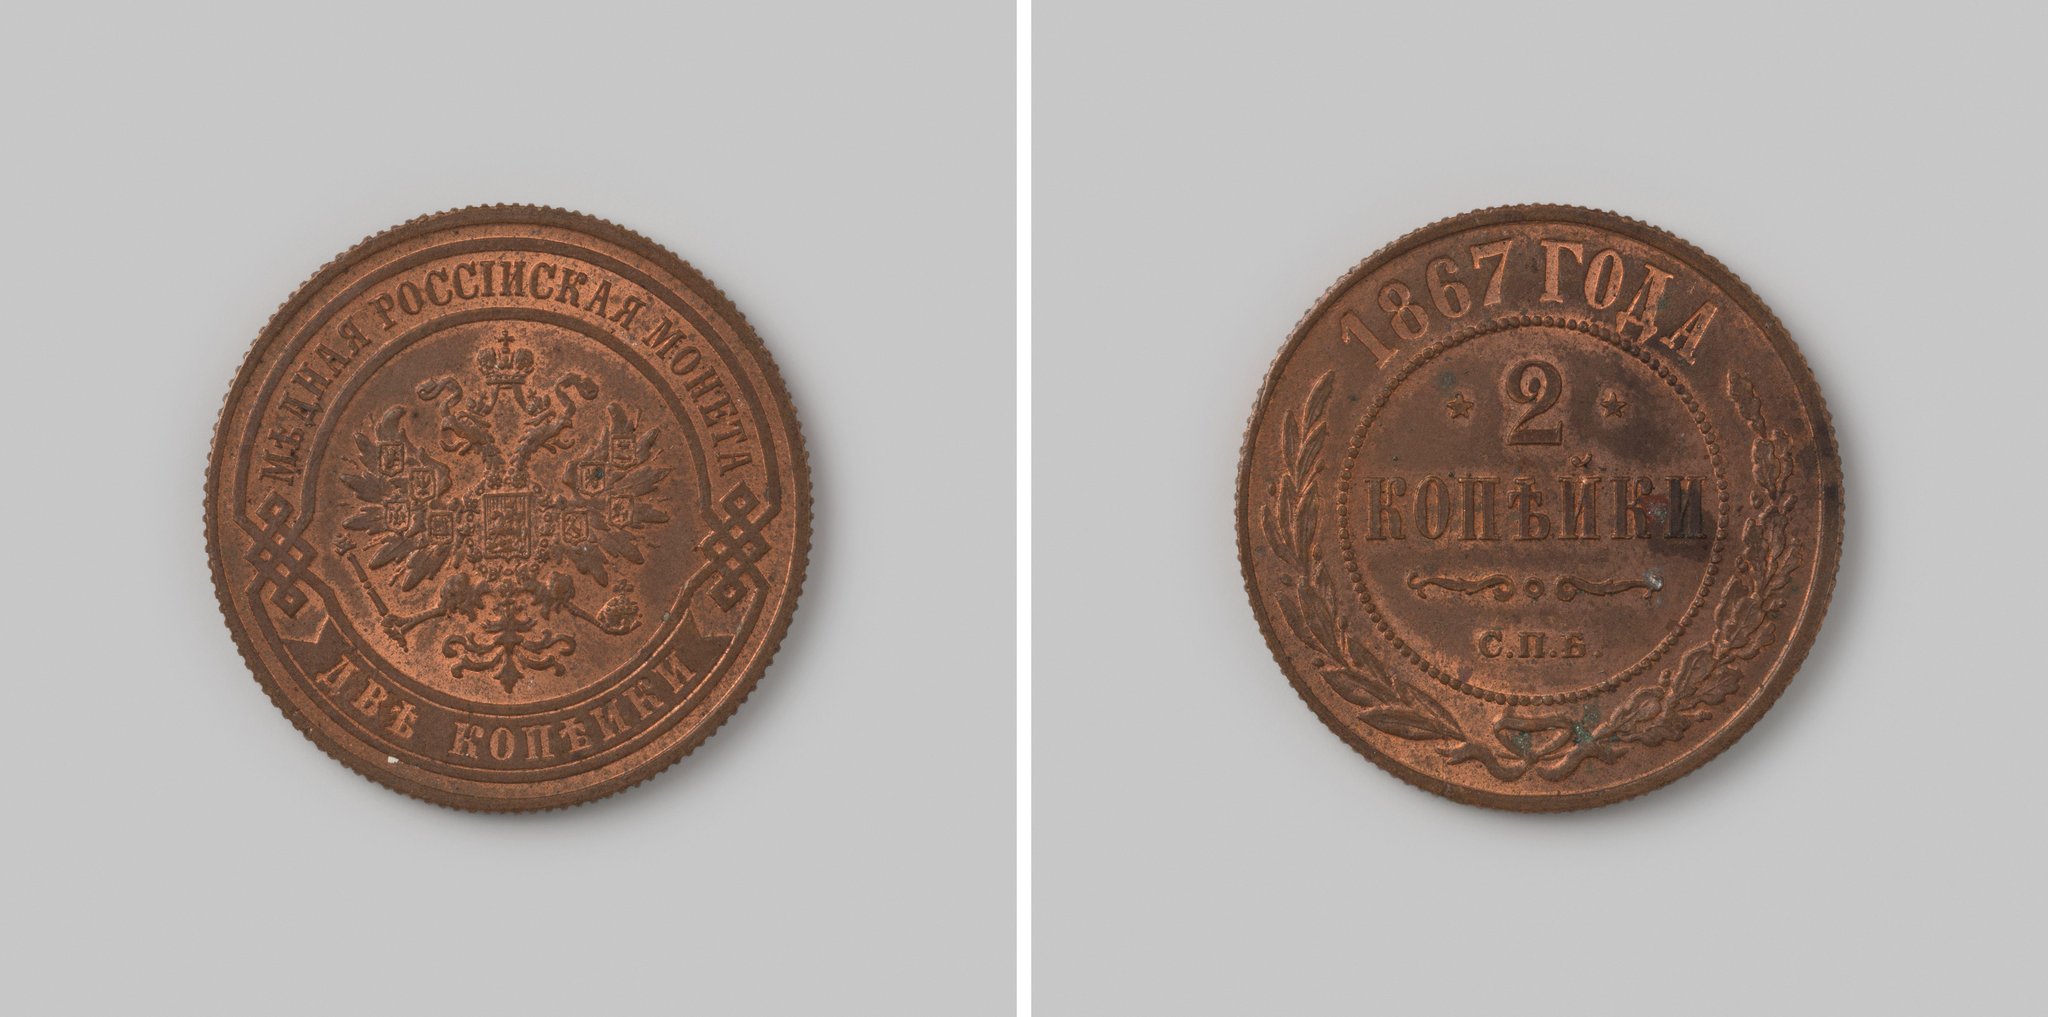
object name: coin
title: 2 kopeken uit Rusland van tsaar Alexander II, 1867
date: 1867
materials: copper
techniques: striking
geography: sint-petersburg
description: Koperen munt. Voorzijde: dubbelkoppige gekroonde adelaar met gespreide vleugels en met op zijn vleugels kleine wapenschilden en op zijn borst een groot, met een ridderorde omhangen wapenschild en in zijn poten een scepter en een gekroonde bol. Boven de adelaar een kroon met lint. Waarde-aanduiding in omschrift onderaan. Keerzijde: tussen twee samengebonden takken in twee regels waarde-aanduiding. Daaronder in het Cyrillisch de letters S,P en B [=Sint Petersburg]. Jaartal bovenaan in omschrift. Kartelrand.